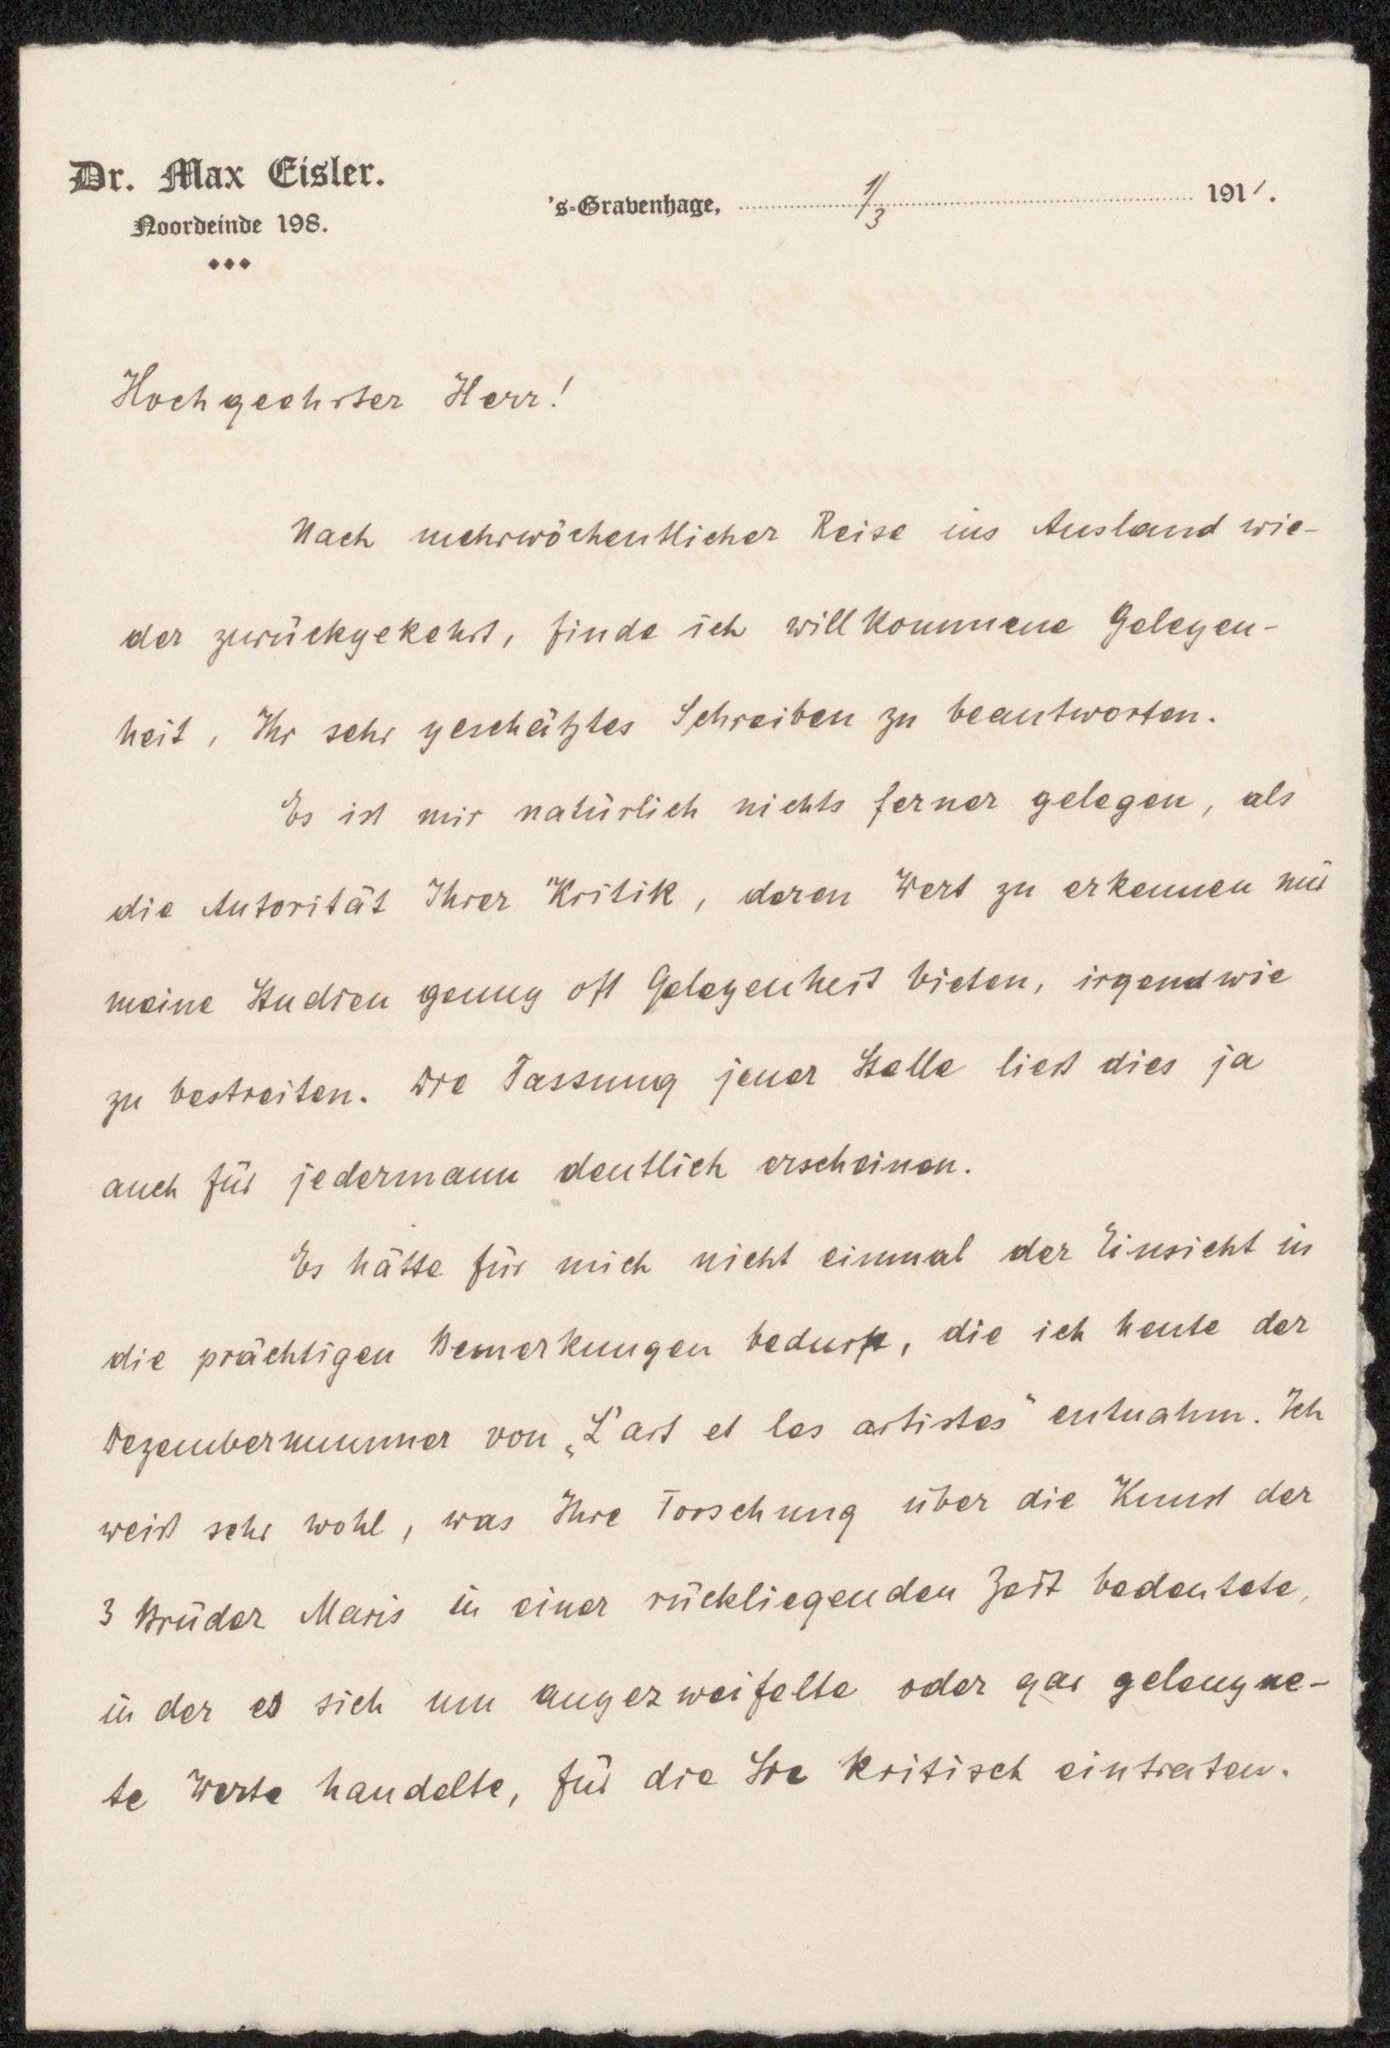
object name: letter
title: Brief aan Philip Zilcken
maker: max eisler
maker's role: kunsthistoricus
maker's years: 1881-1937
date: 1911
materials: ink, paper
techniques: pen, printing, writing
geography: the hague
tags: london, matthijs maris, willem maris, the hague, painter, print maker, draughtsman, jacob maris, philip zilcken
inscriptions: collector's mark: ‘RPK’, watermark